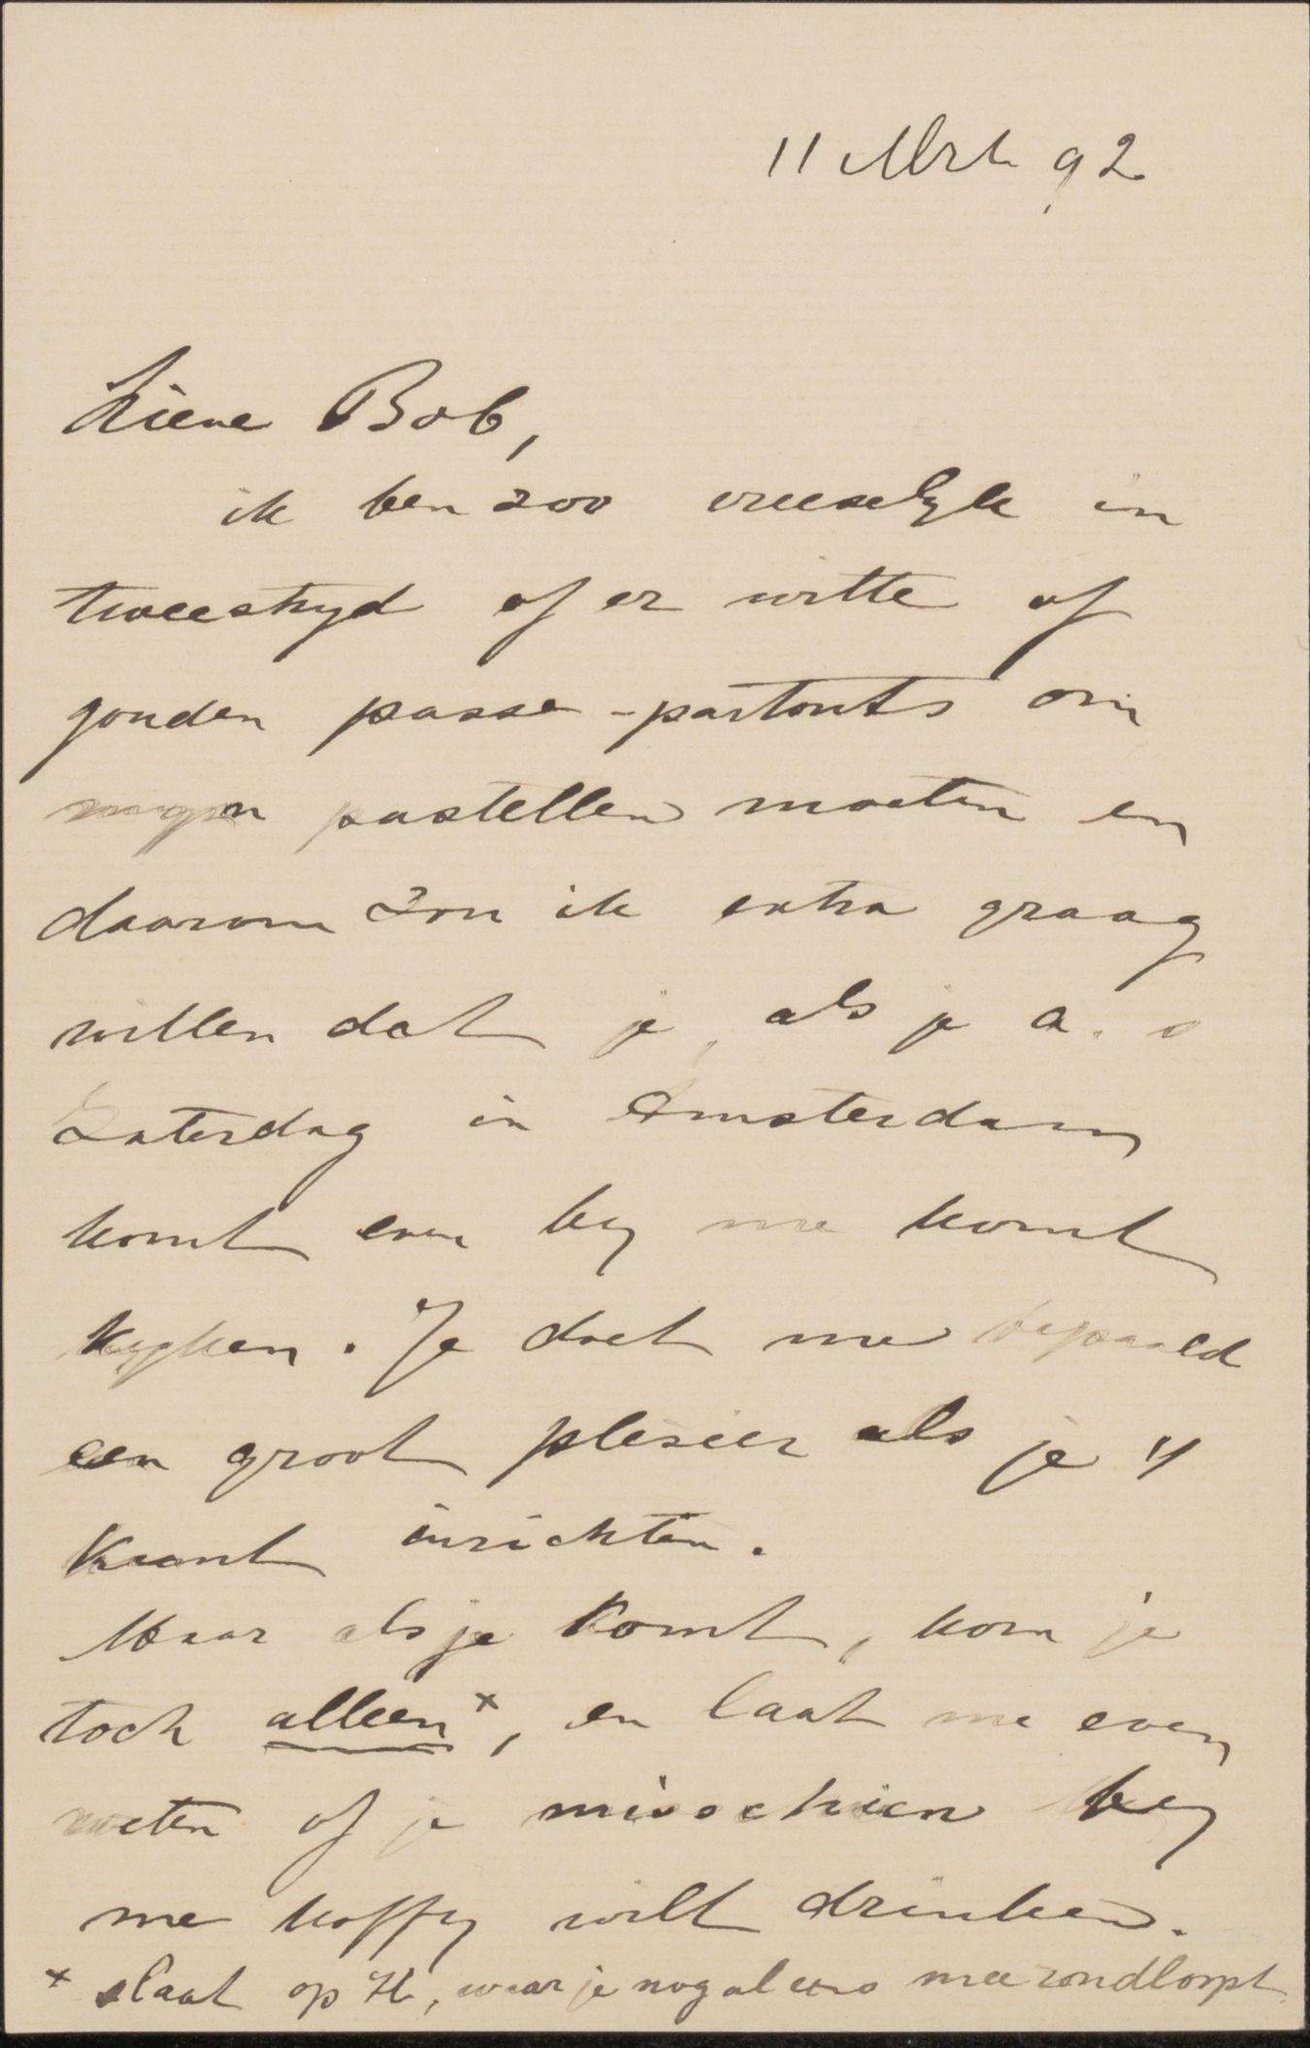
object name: letter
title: Brief aan Jan Veth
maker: wally moes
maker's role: draughtsman, print maker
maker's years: 1856-1918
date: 1874-1918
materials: cardboard, ink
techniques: pen, writing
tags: dordrecht, painter, designer, jan veth, drawing, amsterdam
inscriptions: collector's mark: ‘RPK’